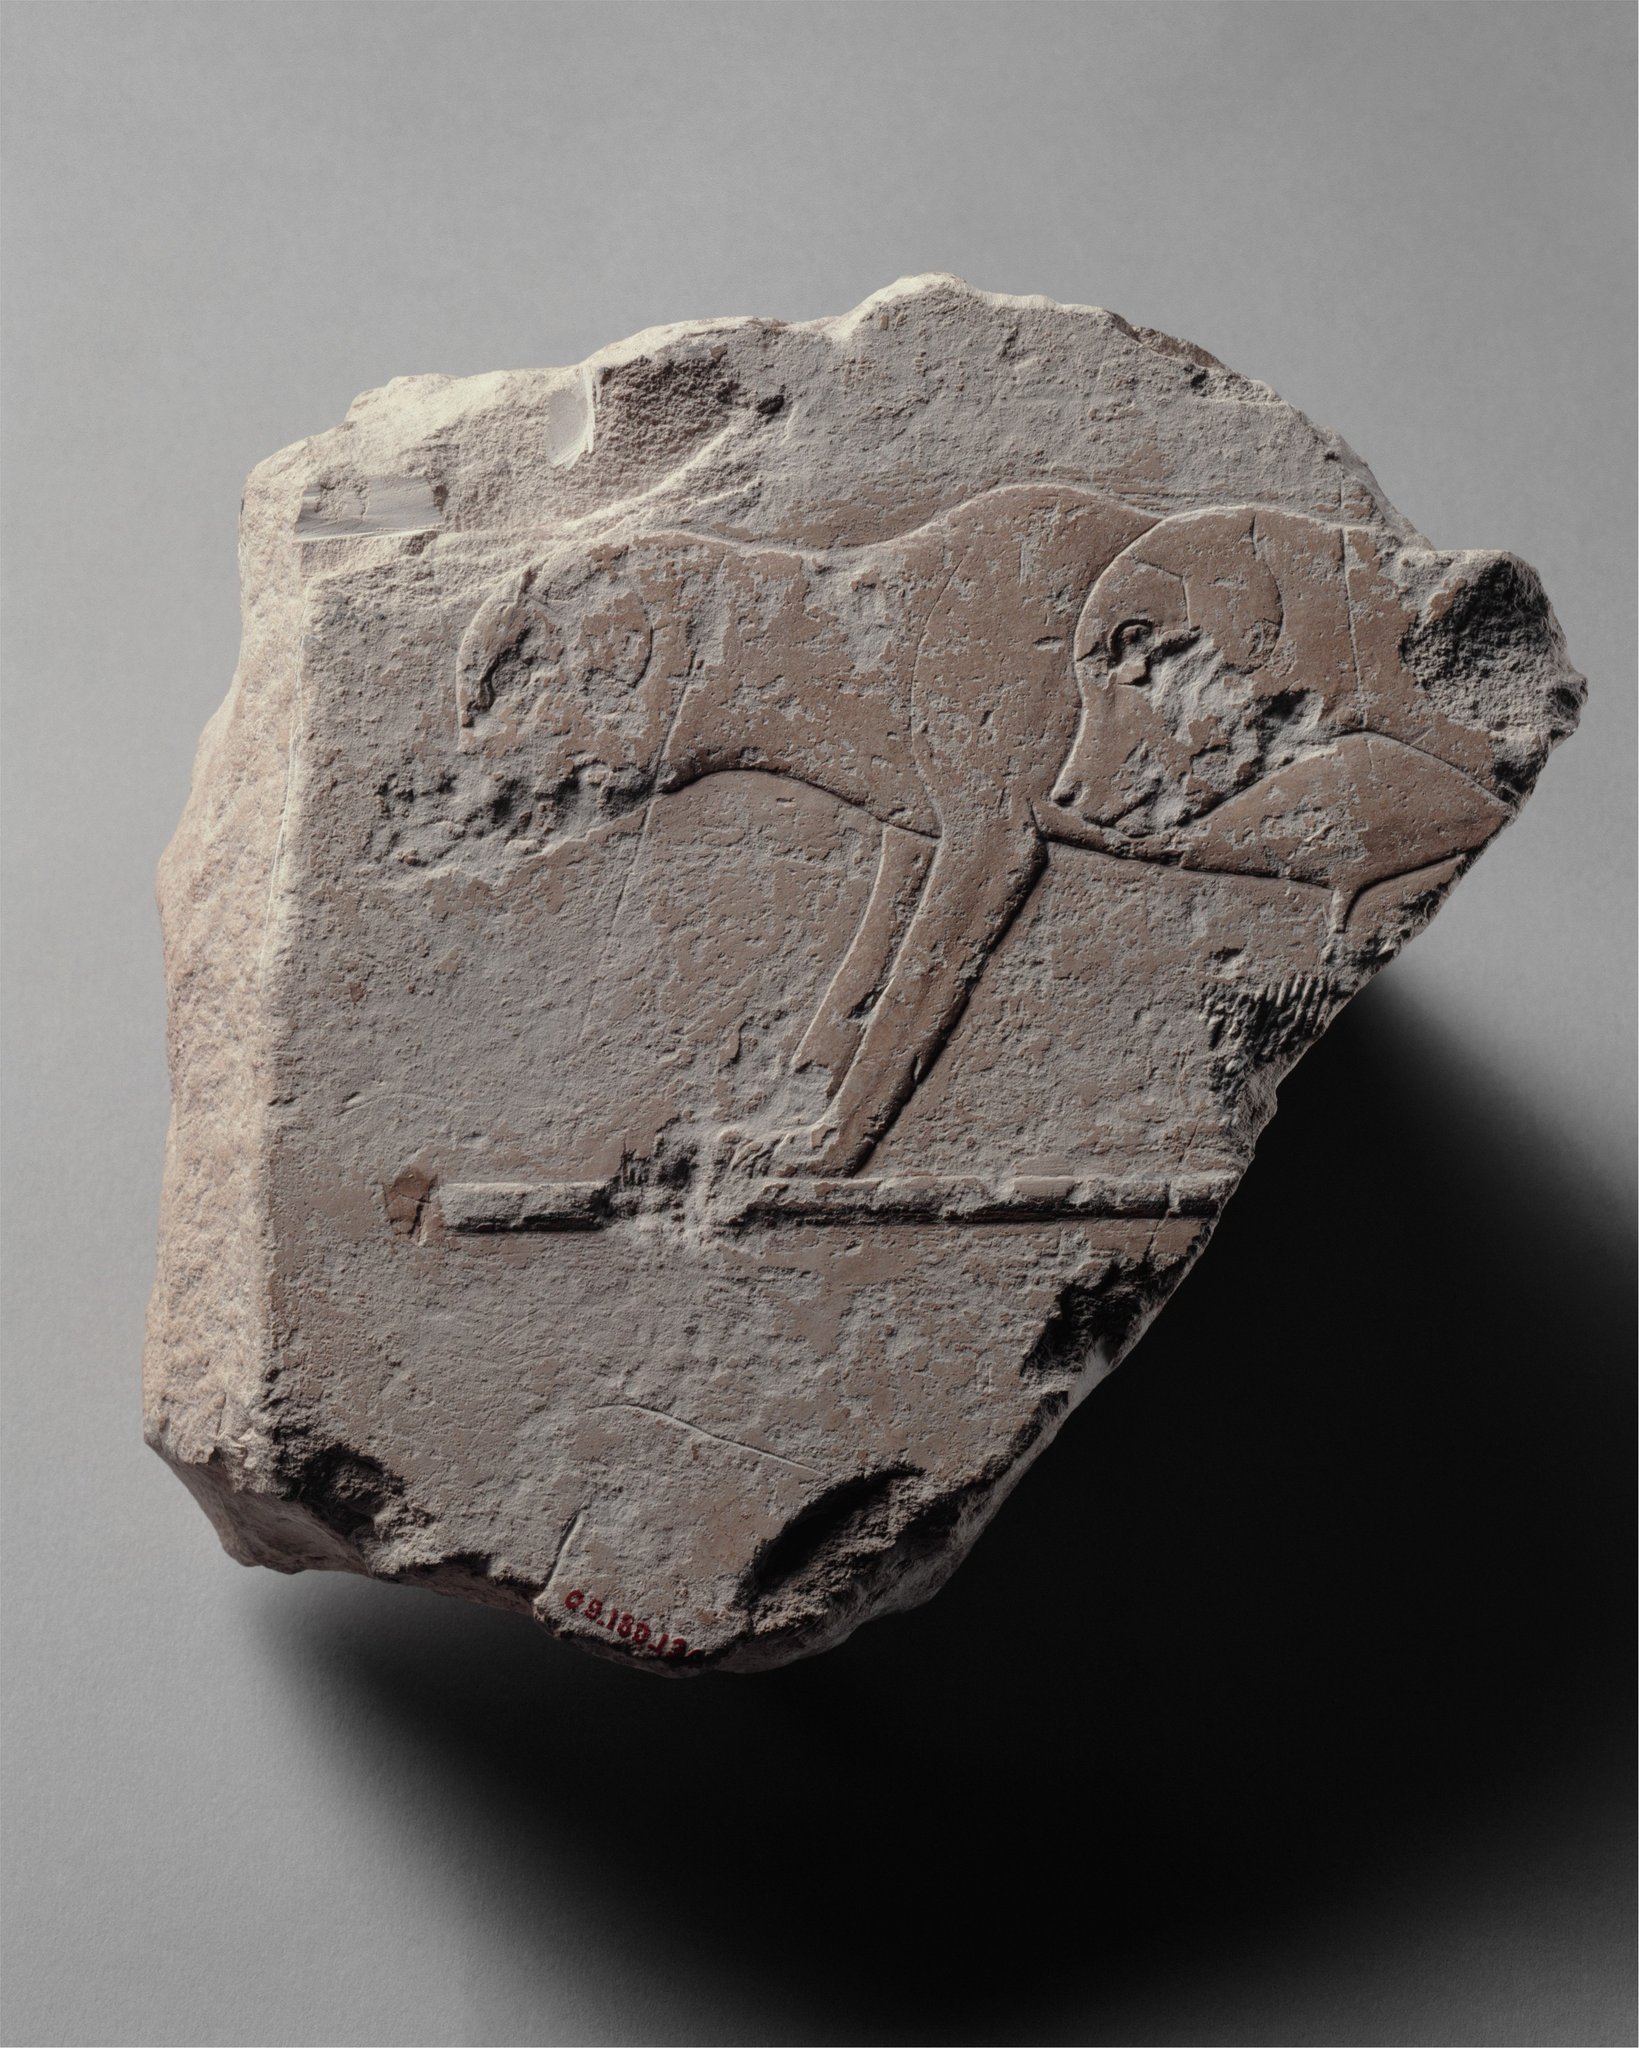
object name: relief, two young dog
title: Relief fragment with two young dogs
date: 2400-2323 BCE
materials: limestone, paint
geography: egypt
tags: dogs